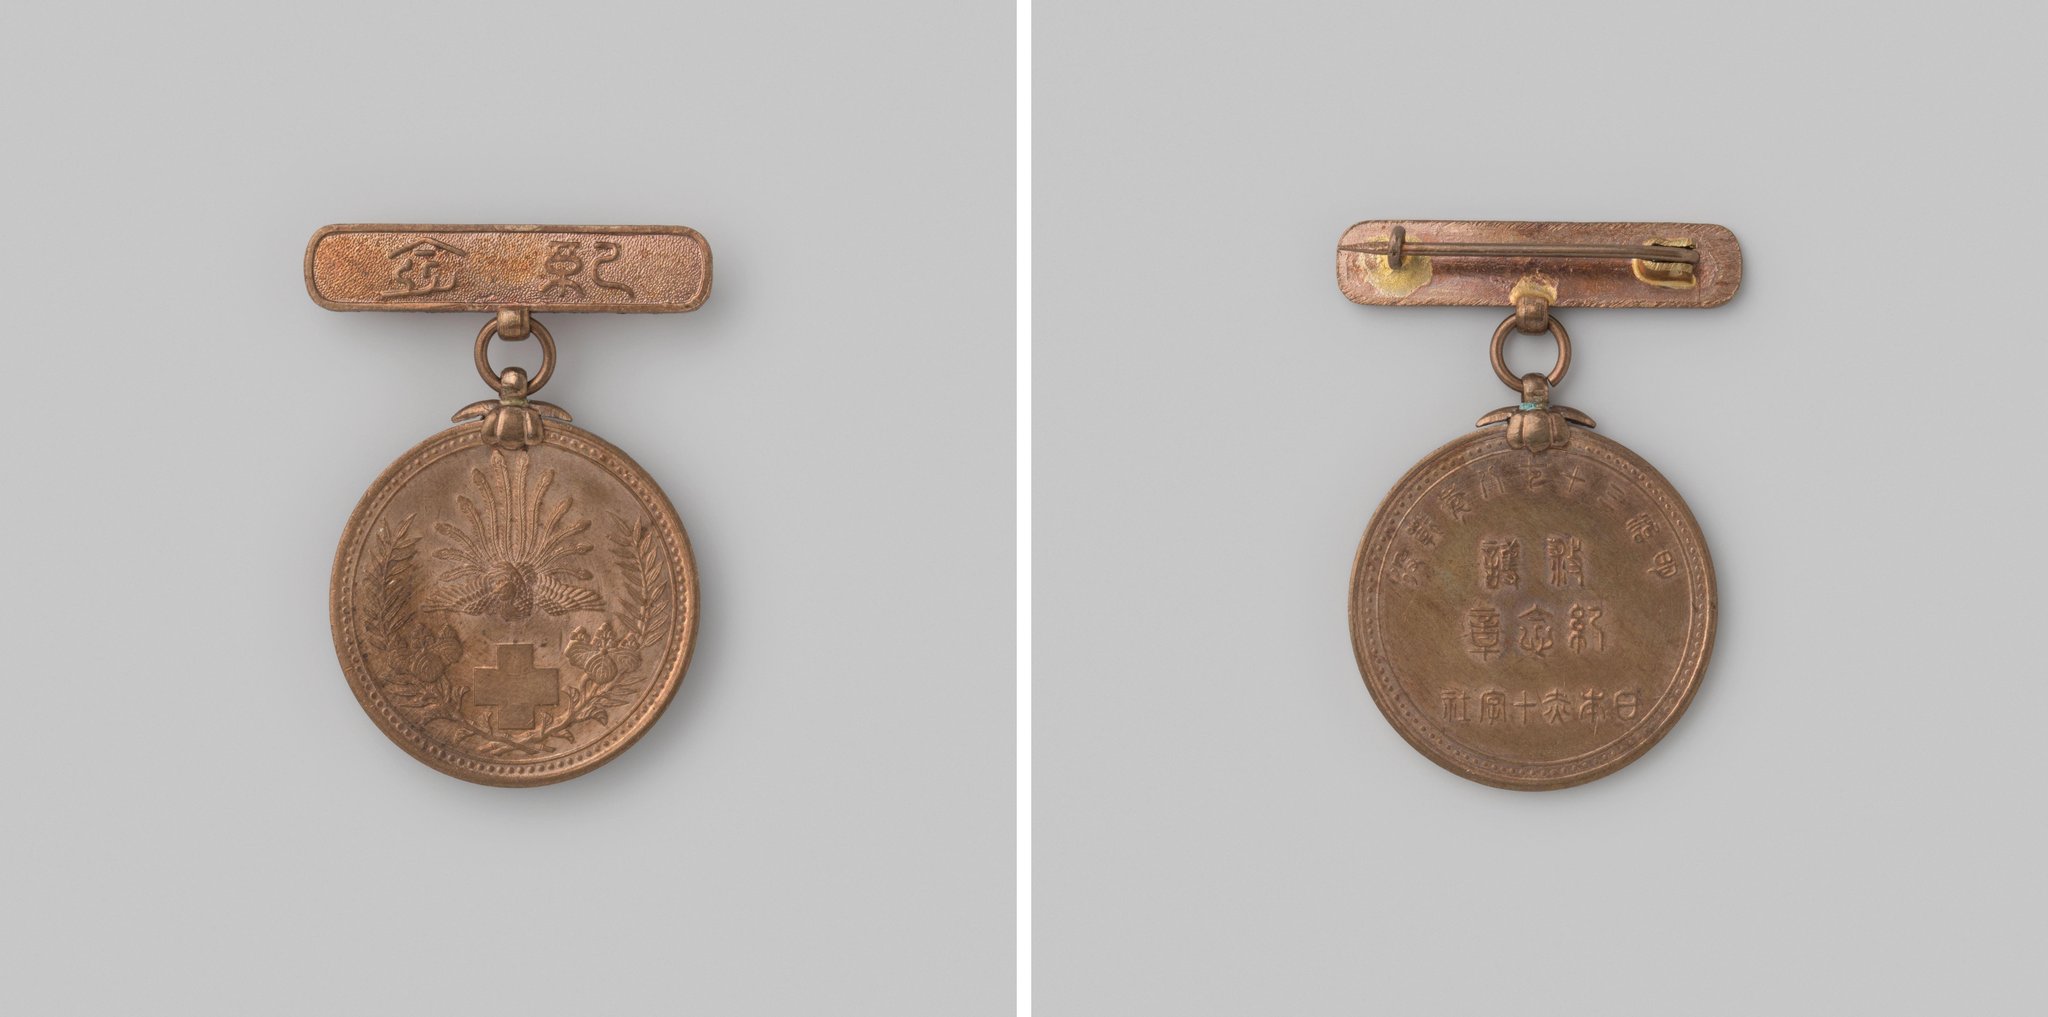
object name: history medal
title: Chinese /Koreaanse draagpenning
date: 1900-1950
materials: bronze, textile, wood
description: Bronzen penning met oog en ring aan een bronzen broche waarop twee karakters, op de voorzijde een paradijsvogel boven een kruis tussen twee takken, op de keerzijde vier regels karakters. In houten doosje met deksel waarin een kussentje met lichtblauwe zijden bekleding.